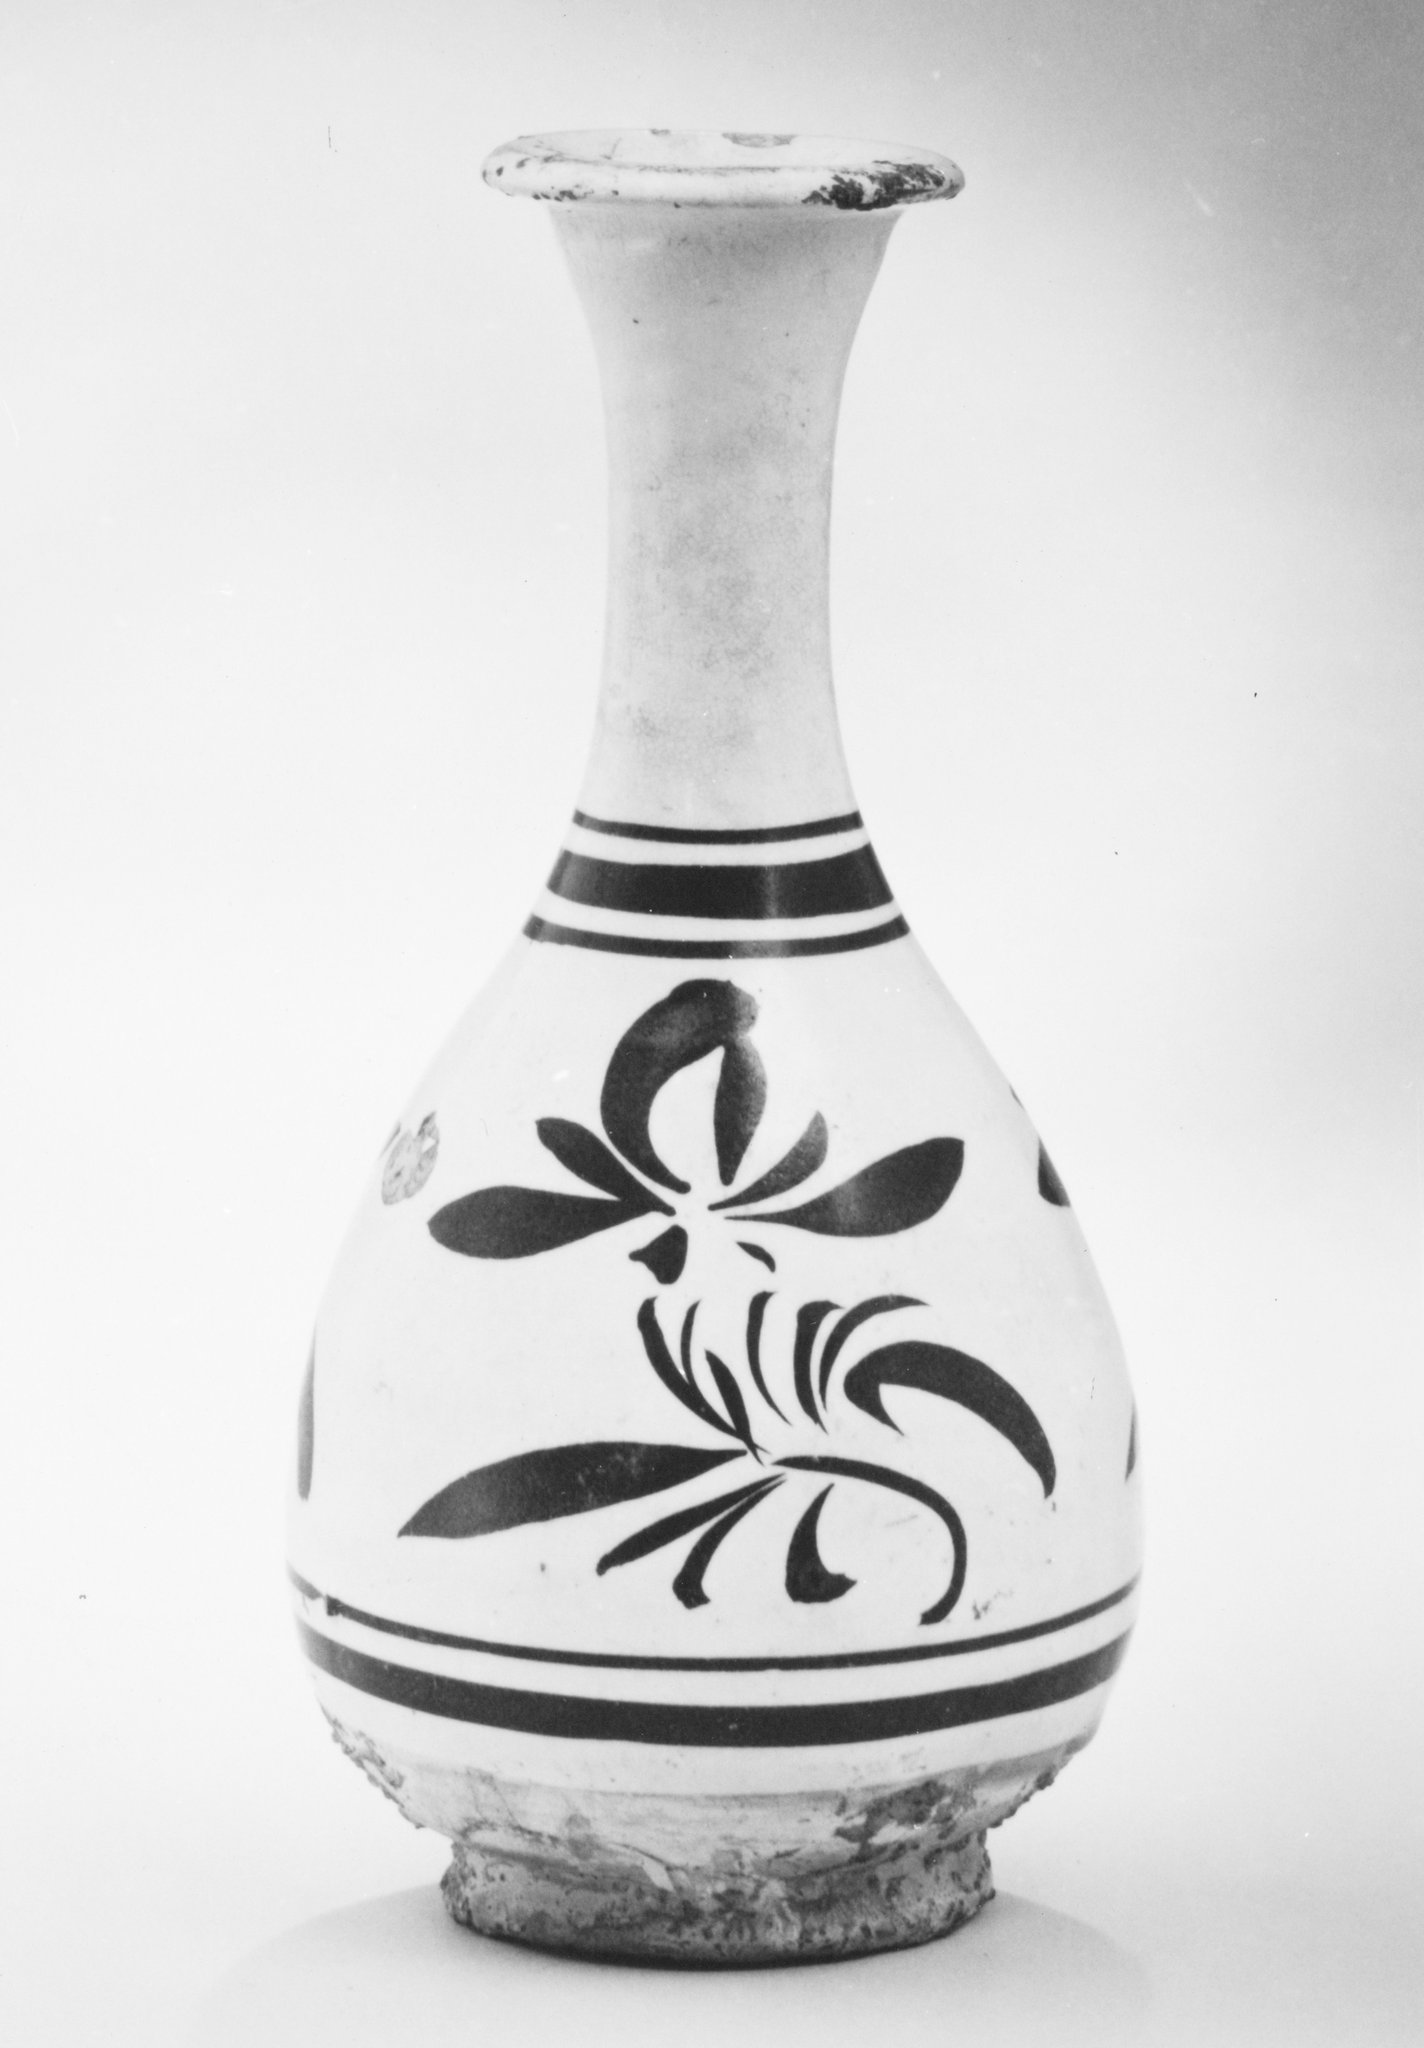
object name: vase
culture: chinese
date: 1101-1300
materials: stoneware